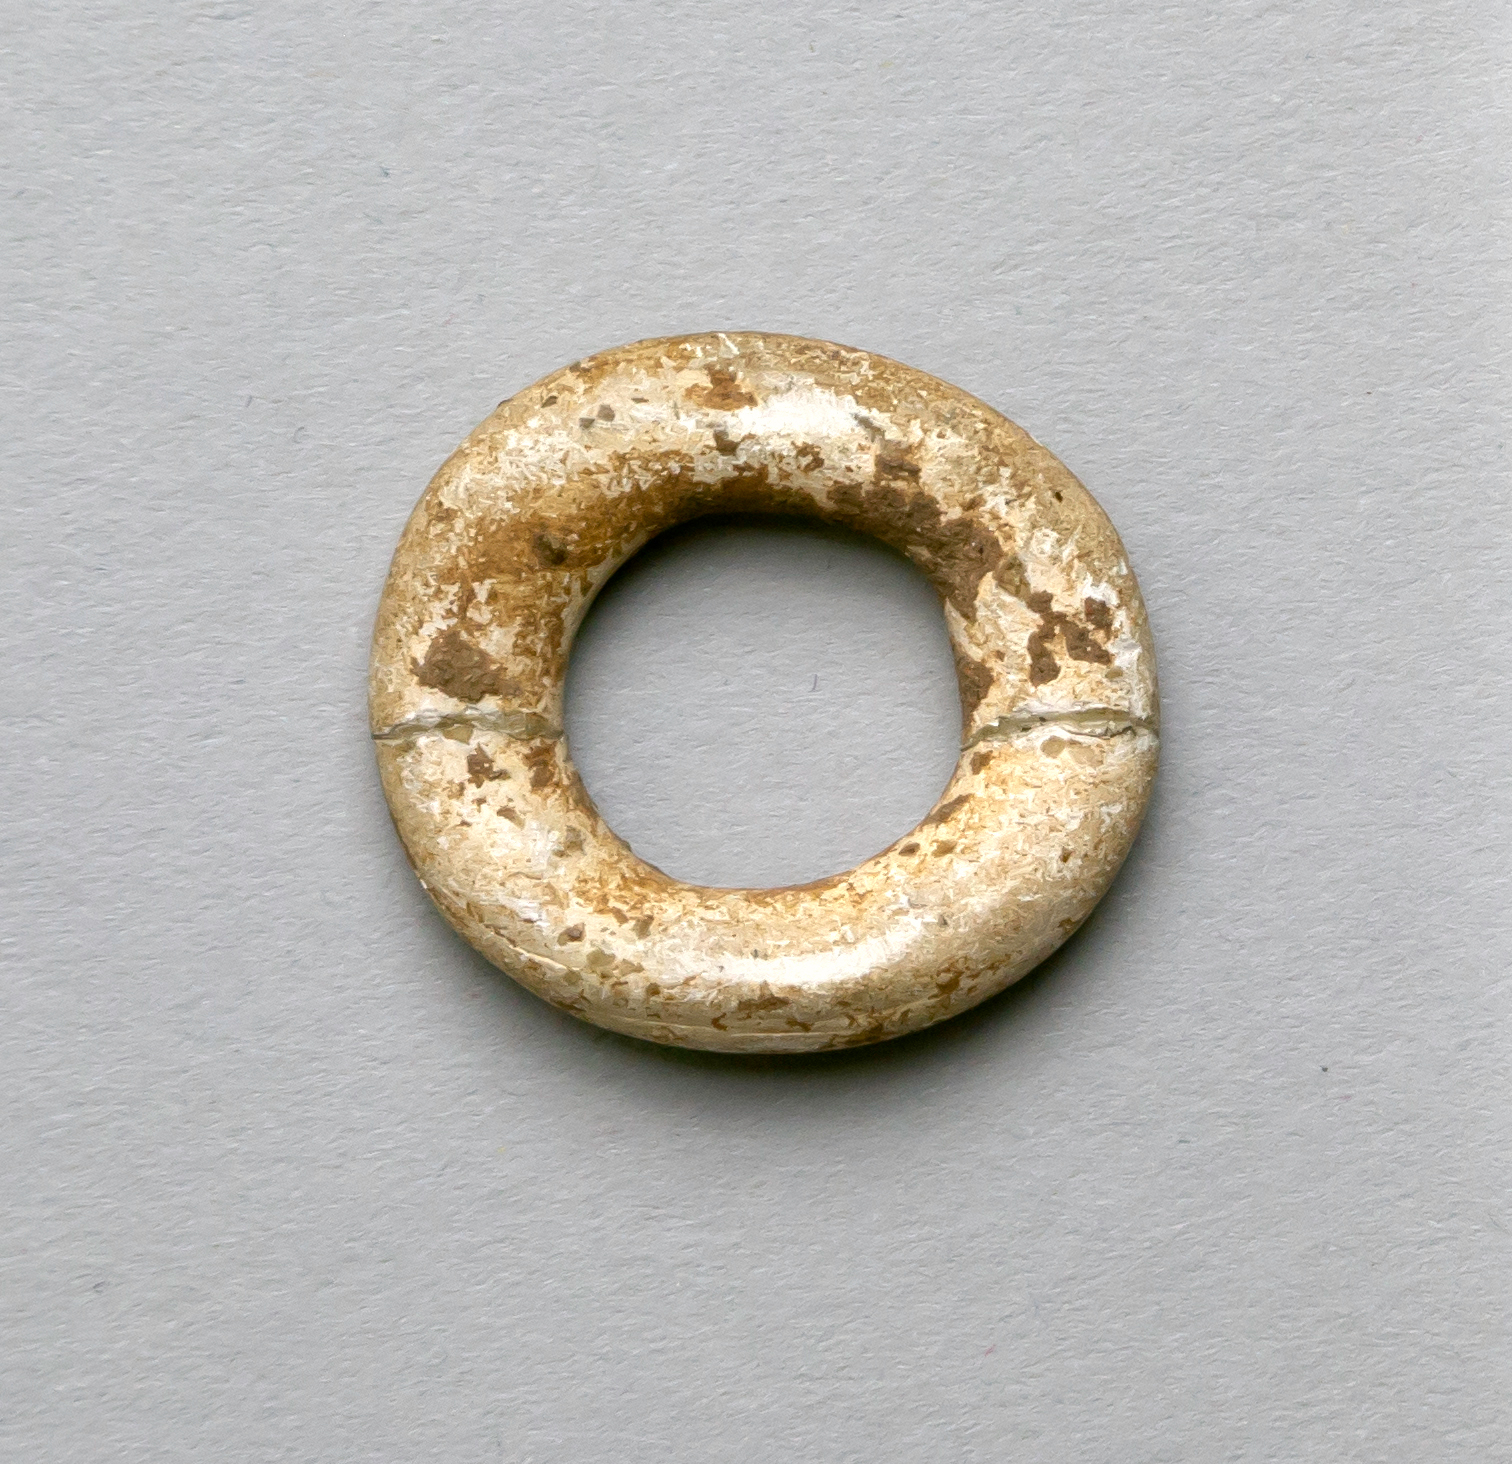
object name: ring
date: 7000 BCE-330 CE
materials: bone